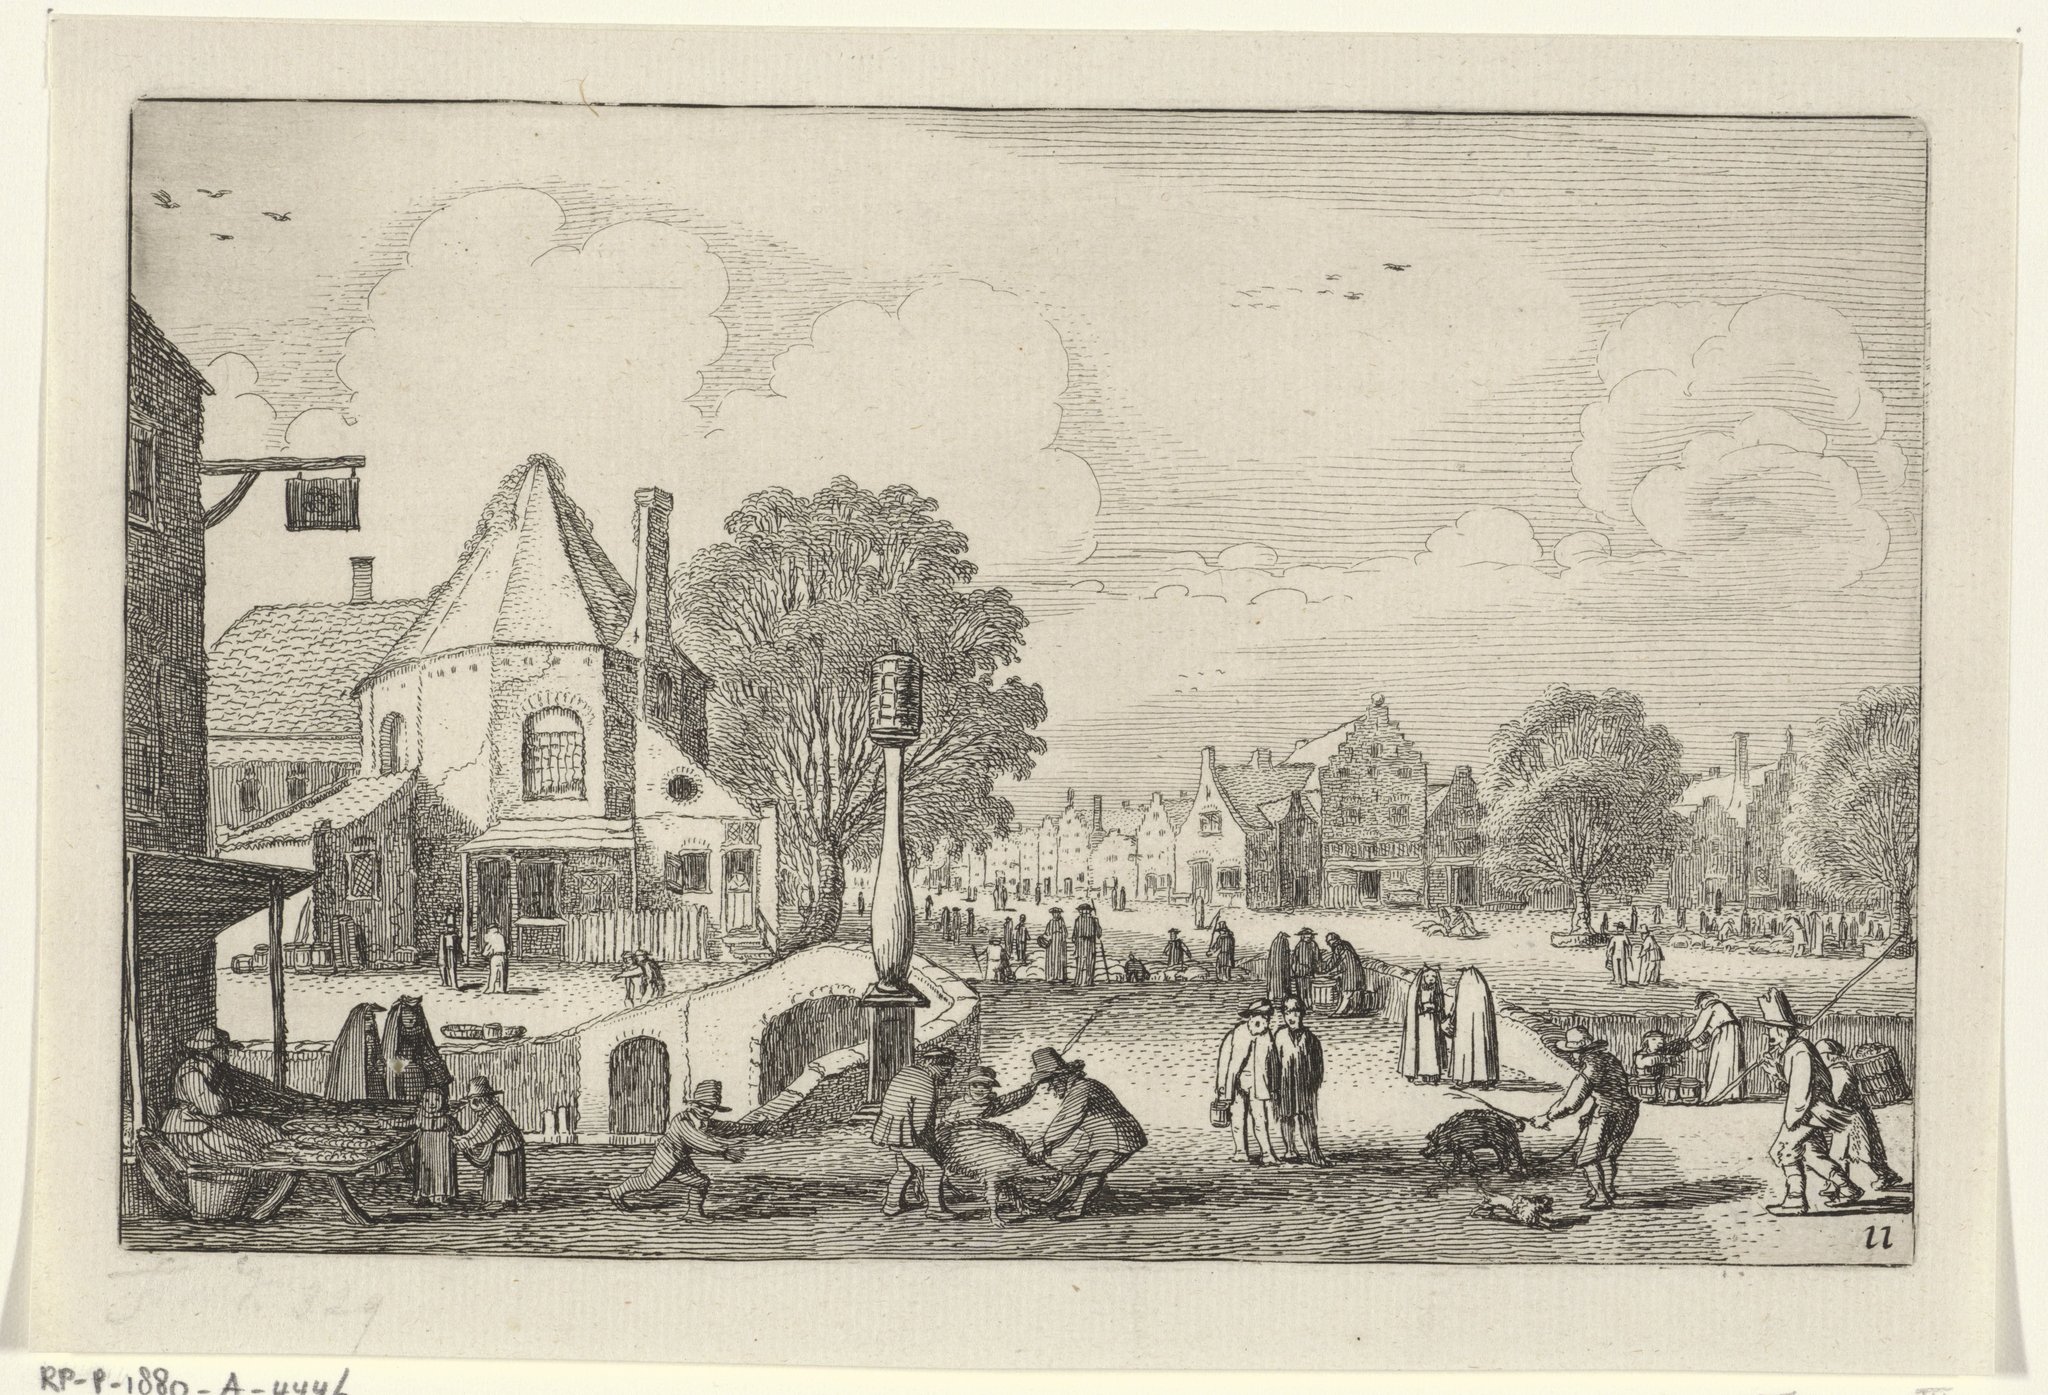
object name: print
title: Marktdag in een stad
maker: jan van de velde (ii)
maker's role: draughtsman, painter, print maker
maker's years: 1593-1641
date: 1616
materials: paper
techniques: etching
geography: northern netherlands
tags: city-view in general; 'veduta', market, bridge in city across river, canal, etc., public road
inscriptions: number: ‘11’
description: Bedrijvigheid tijdens een marktdag in een stad. Elfde prent van deel vijf van een serie van in totaal zestig prenten met landschappen, verdeeld over vijf delen van elk twaalf prenten.